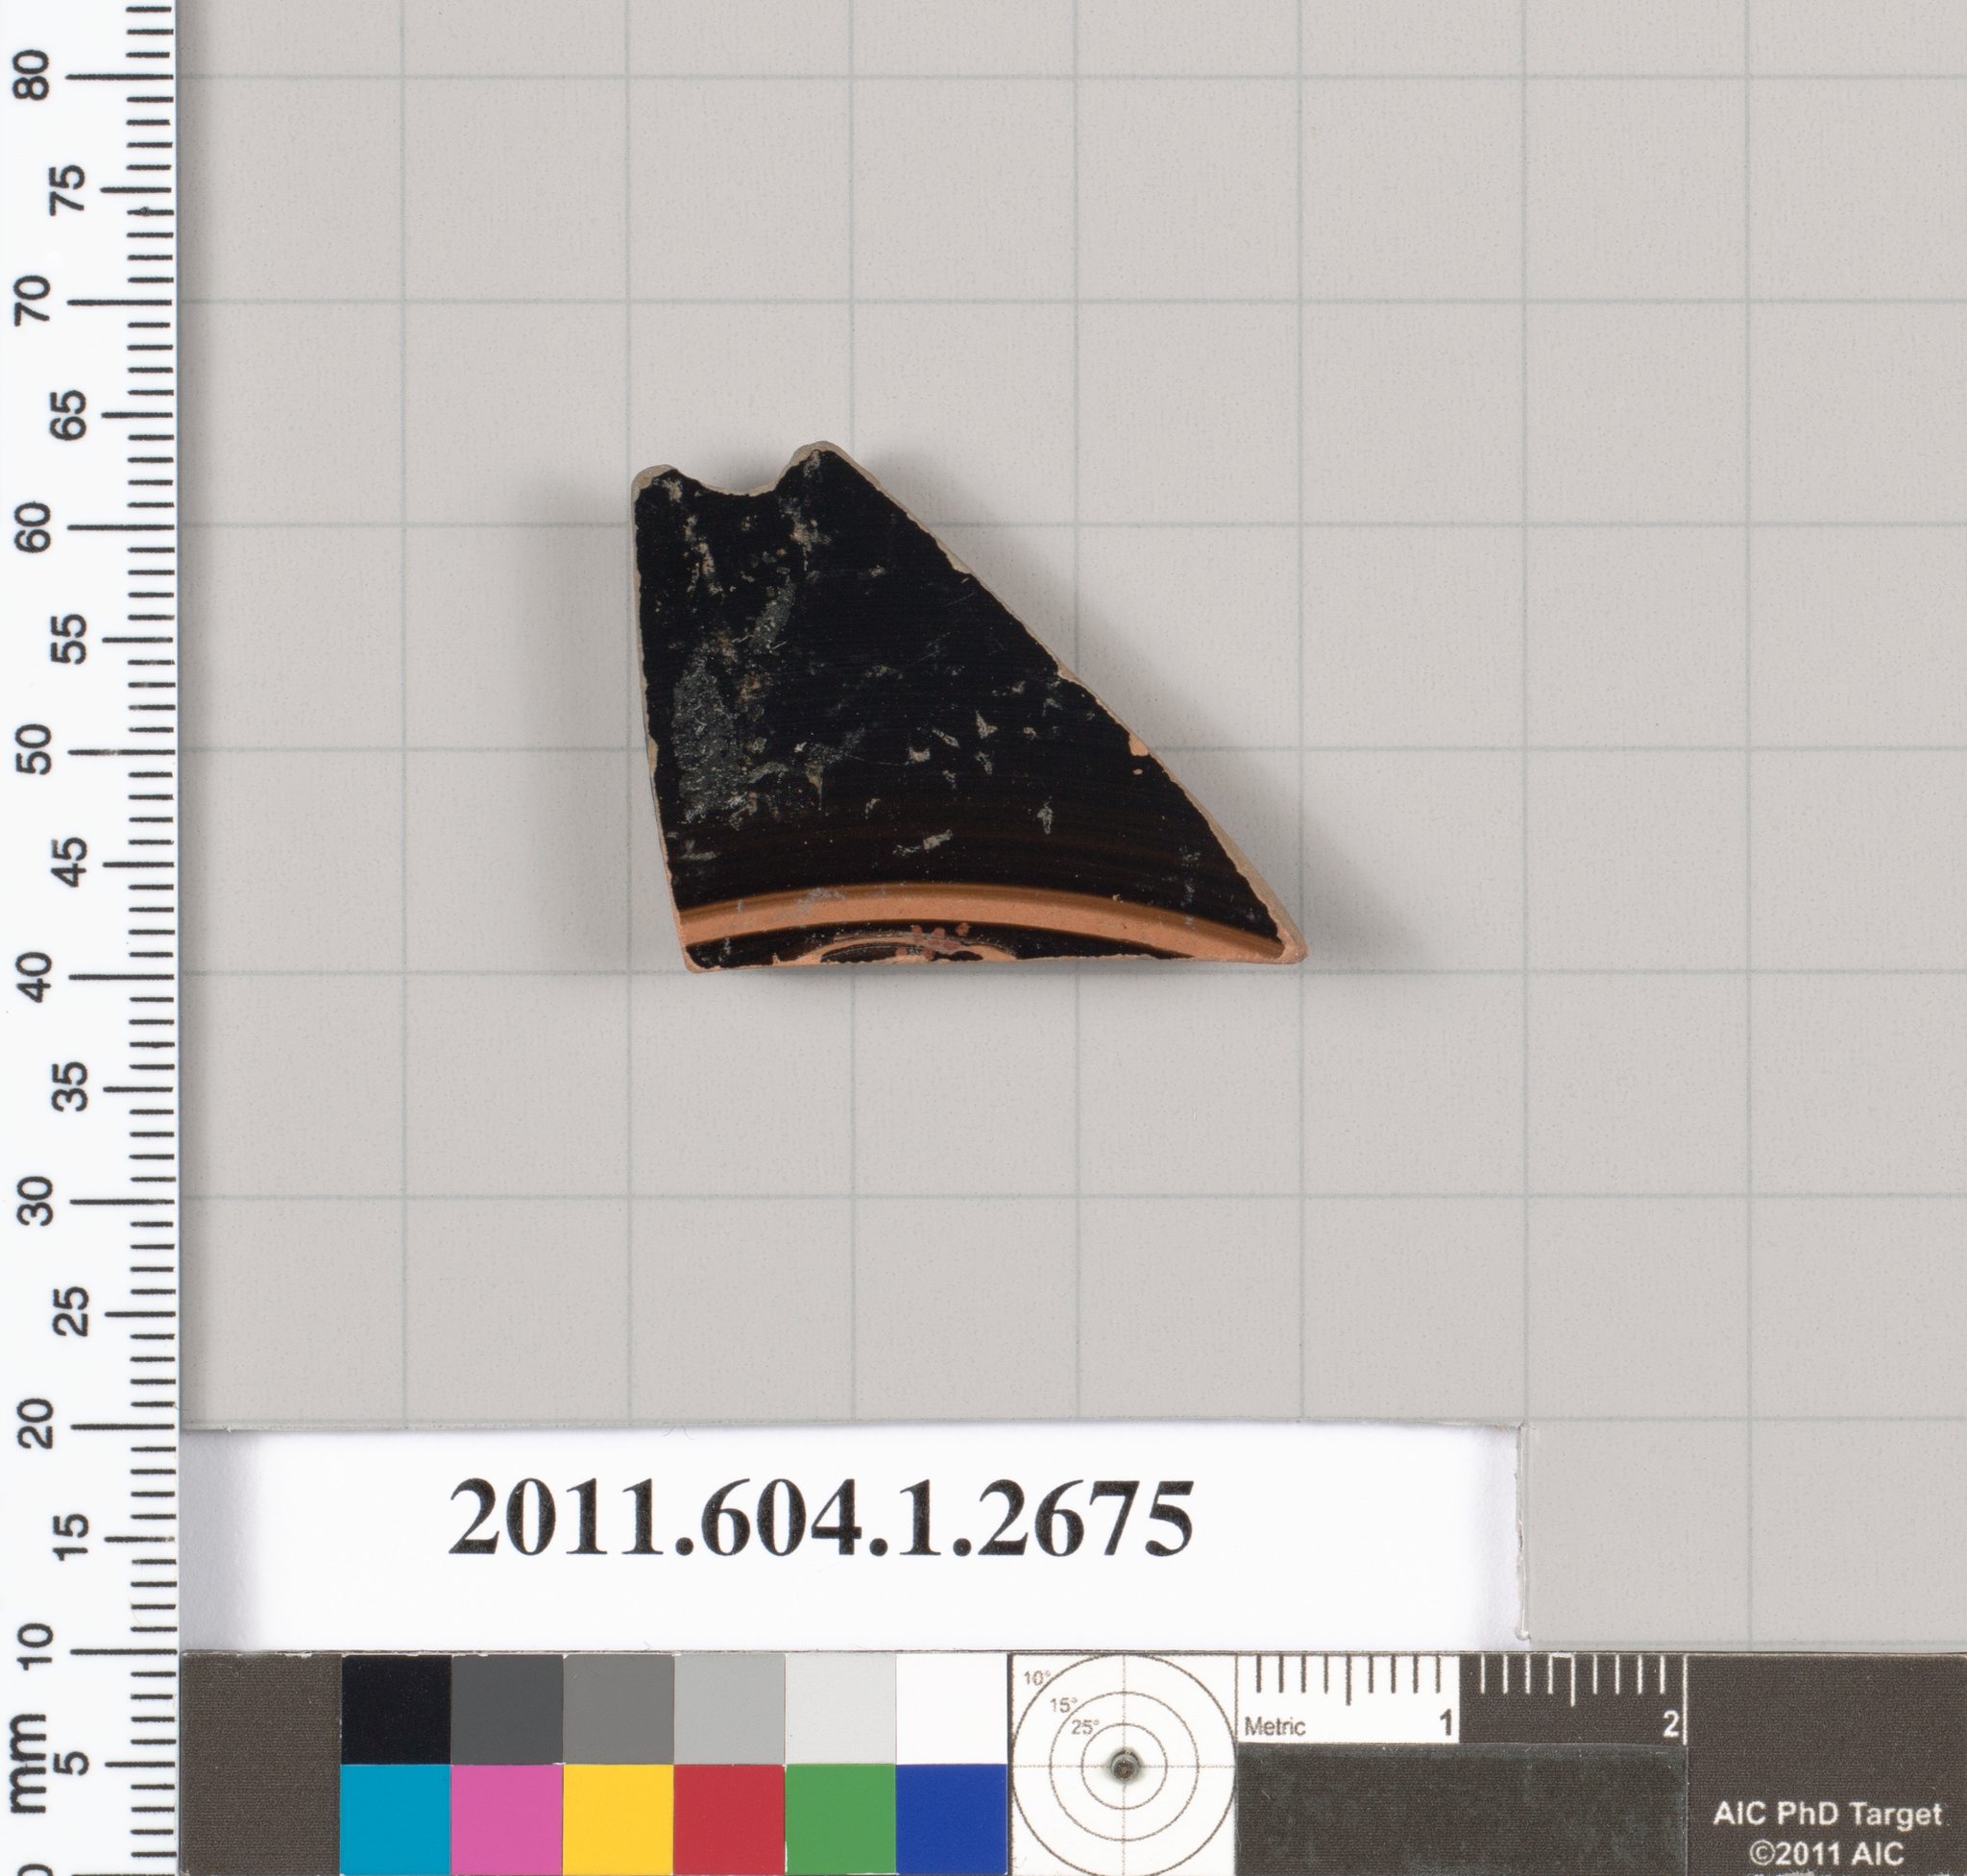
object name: kylix fragment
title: Terracotta fragment of a kylix (drinking cup)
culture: greek, attic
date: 500-476 BCE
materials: terracotta